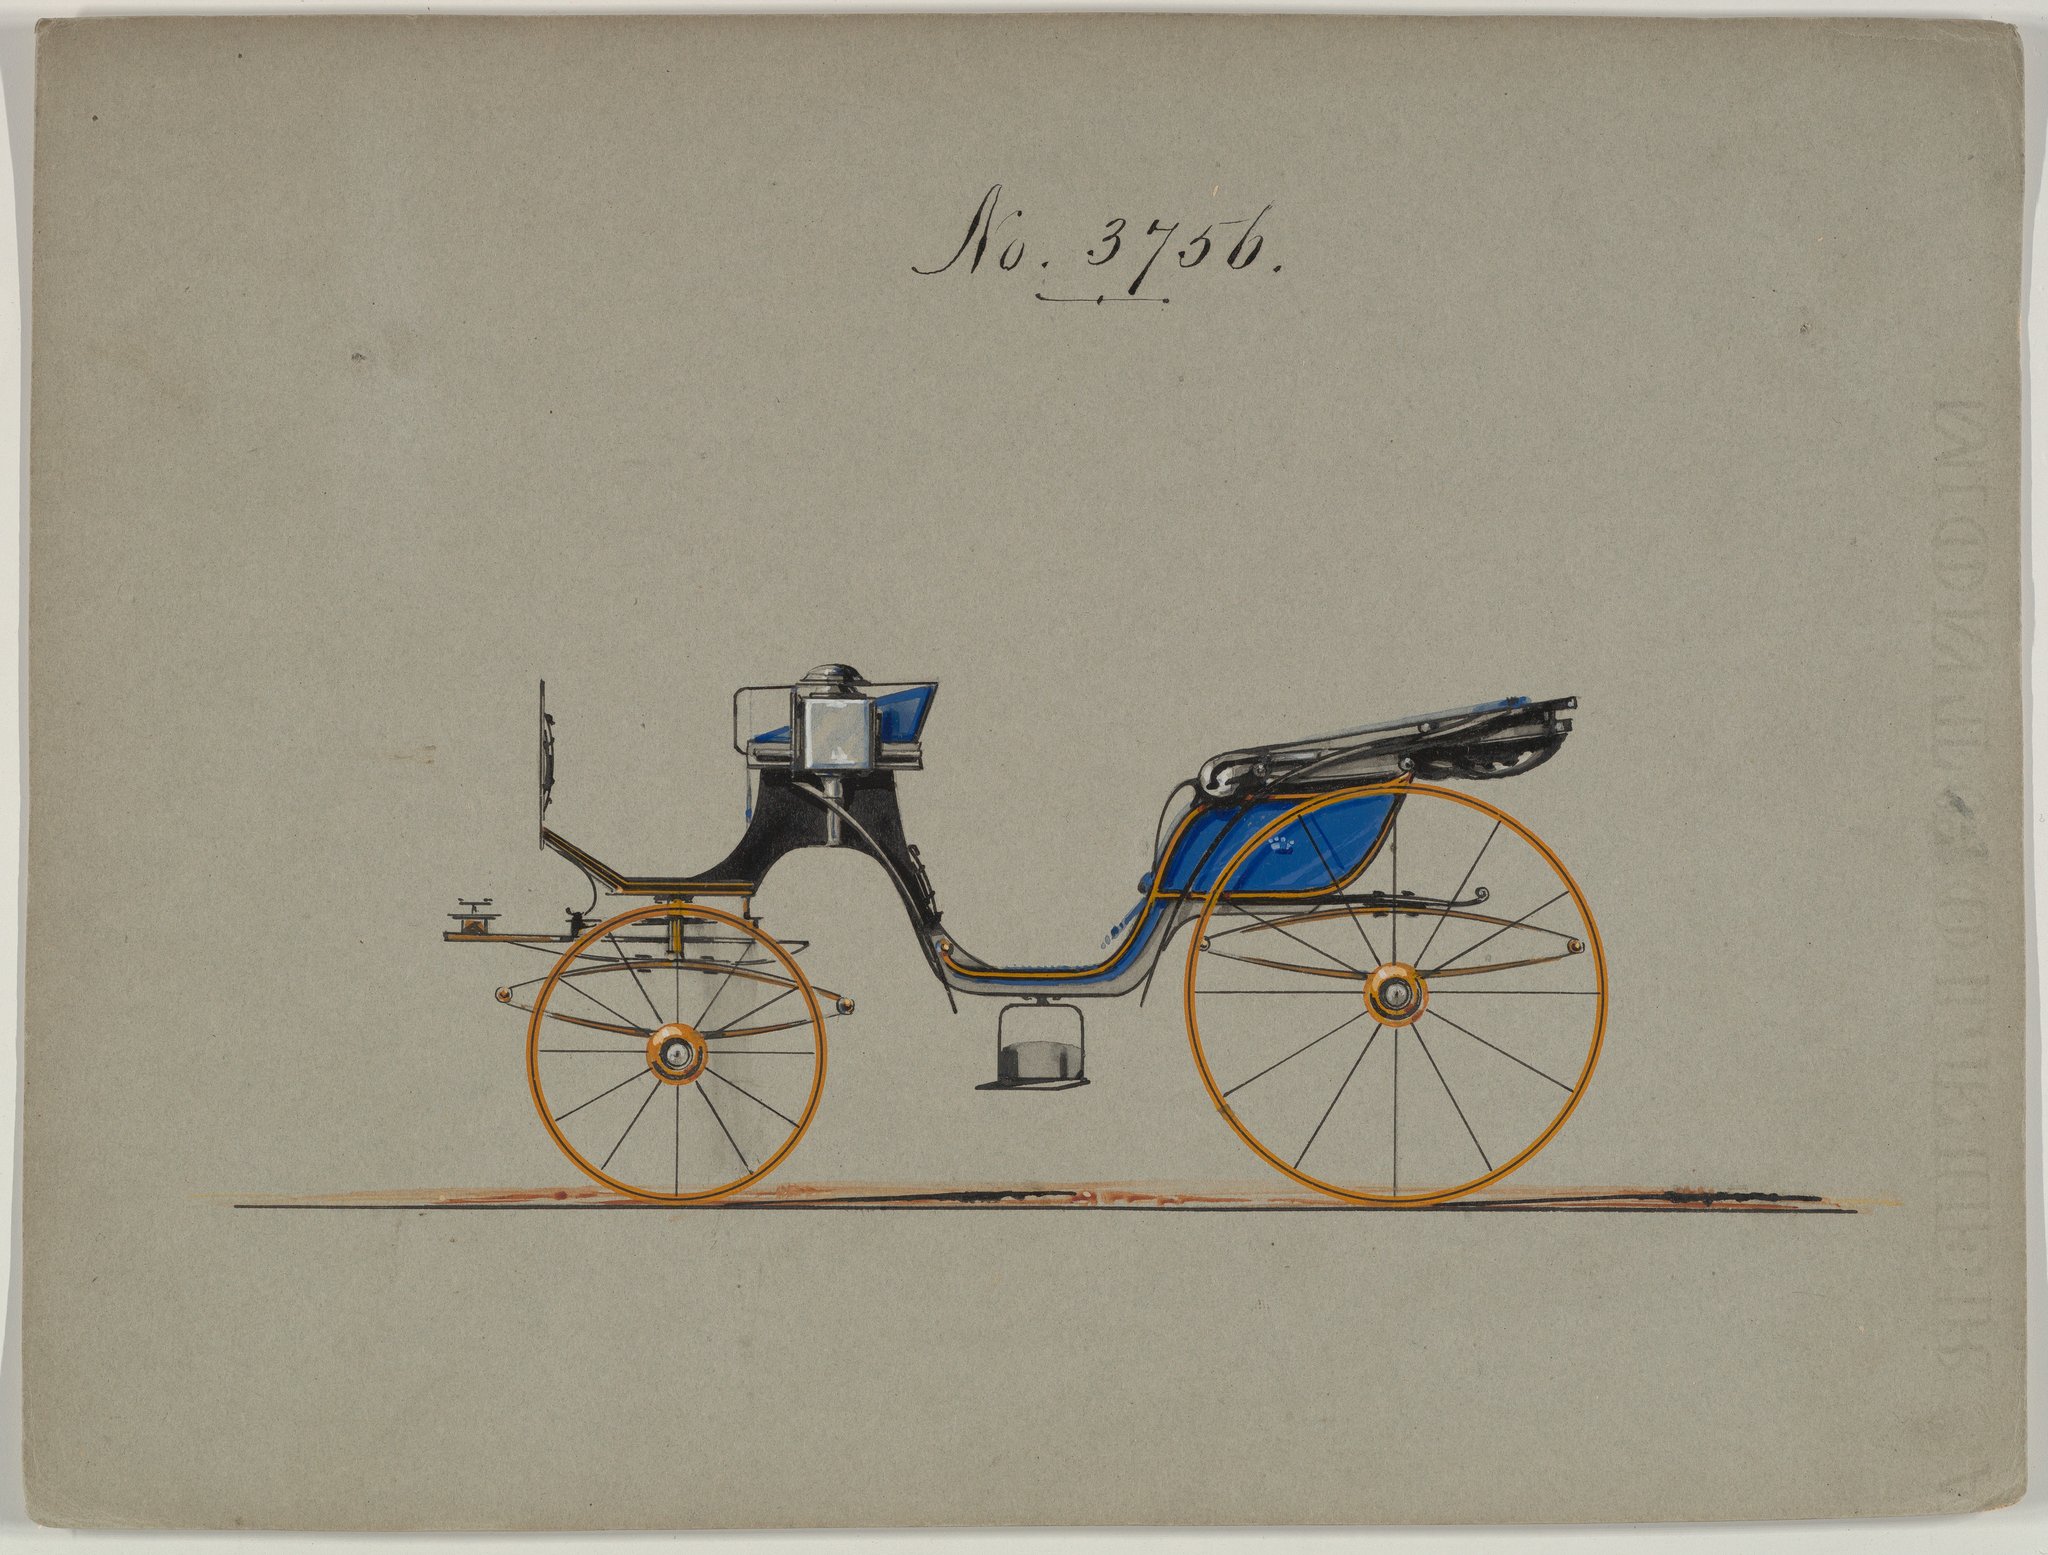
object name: drawing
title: Design for Cabriolet or Victoria, no. 3756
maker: brewster & co.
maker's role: manufacturer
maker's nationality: american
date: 1882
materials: gouache, gum arabic, ink, watercolor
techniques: pen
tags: carriages